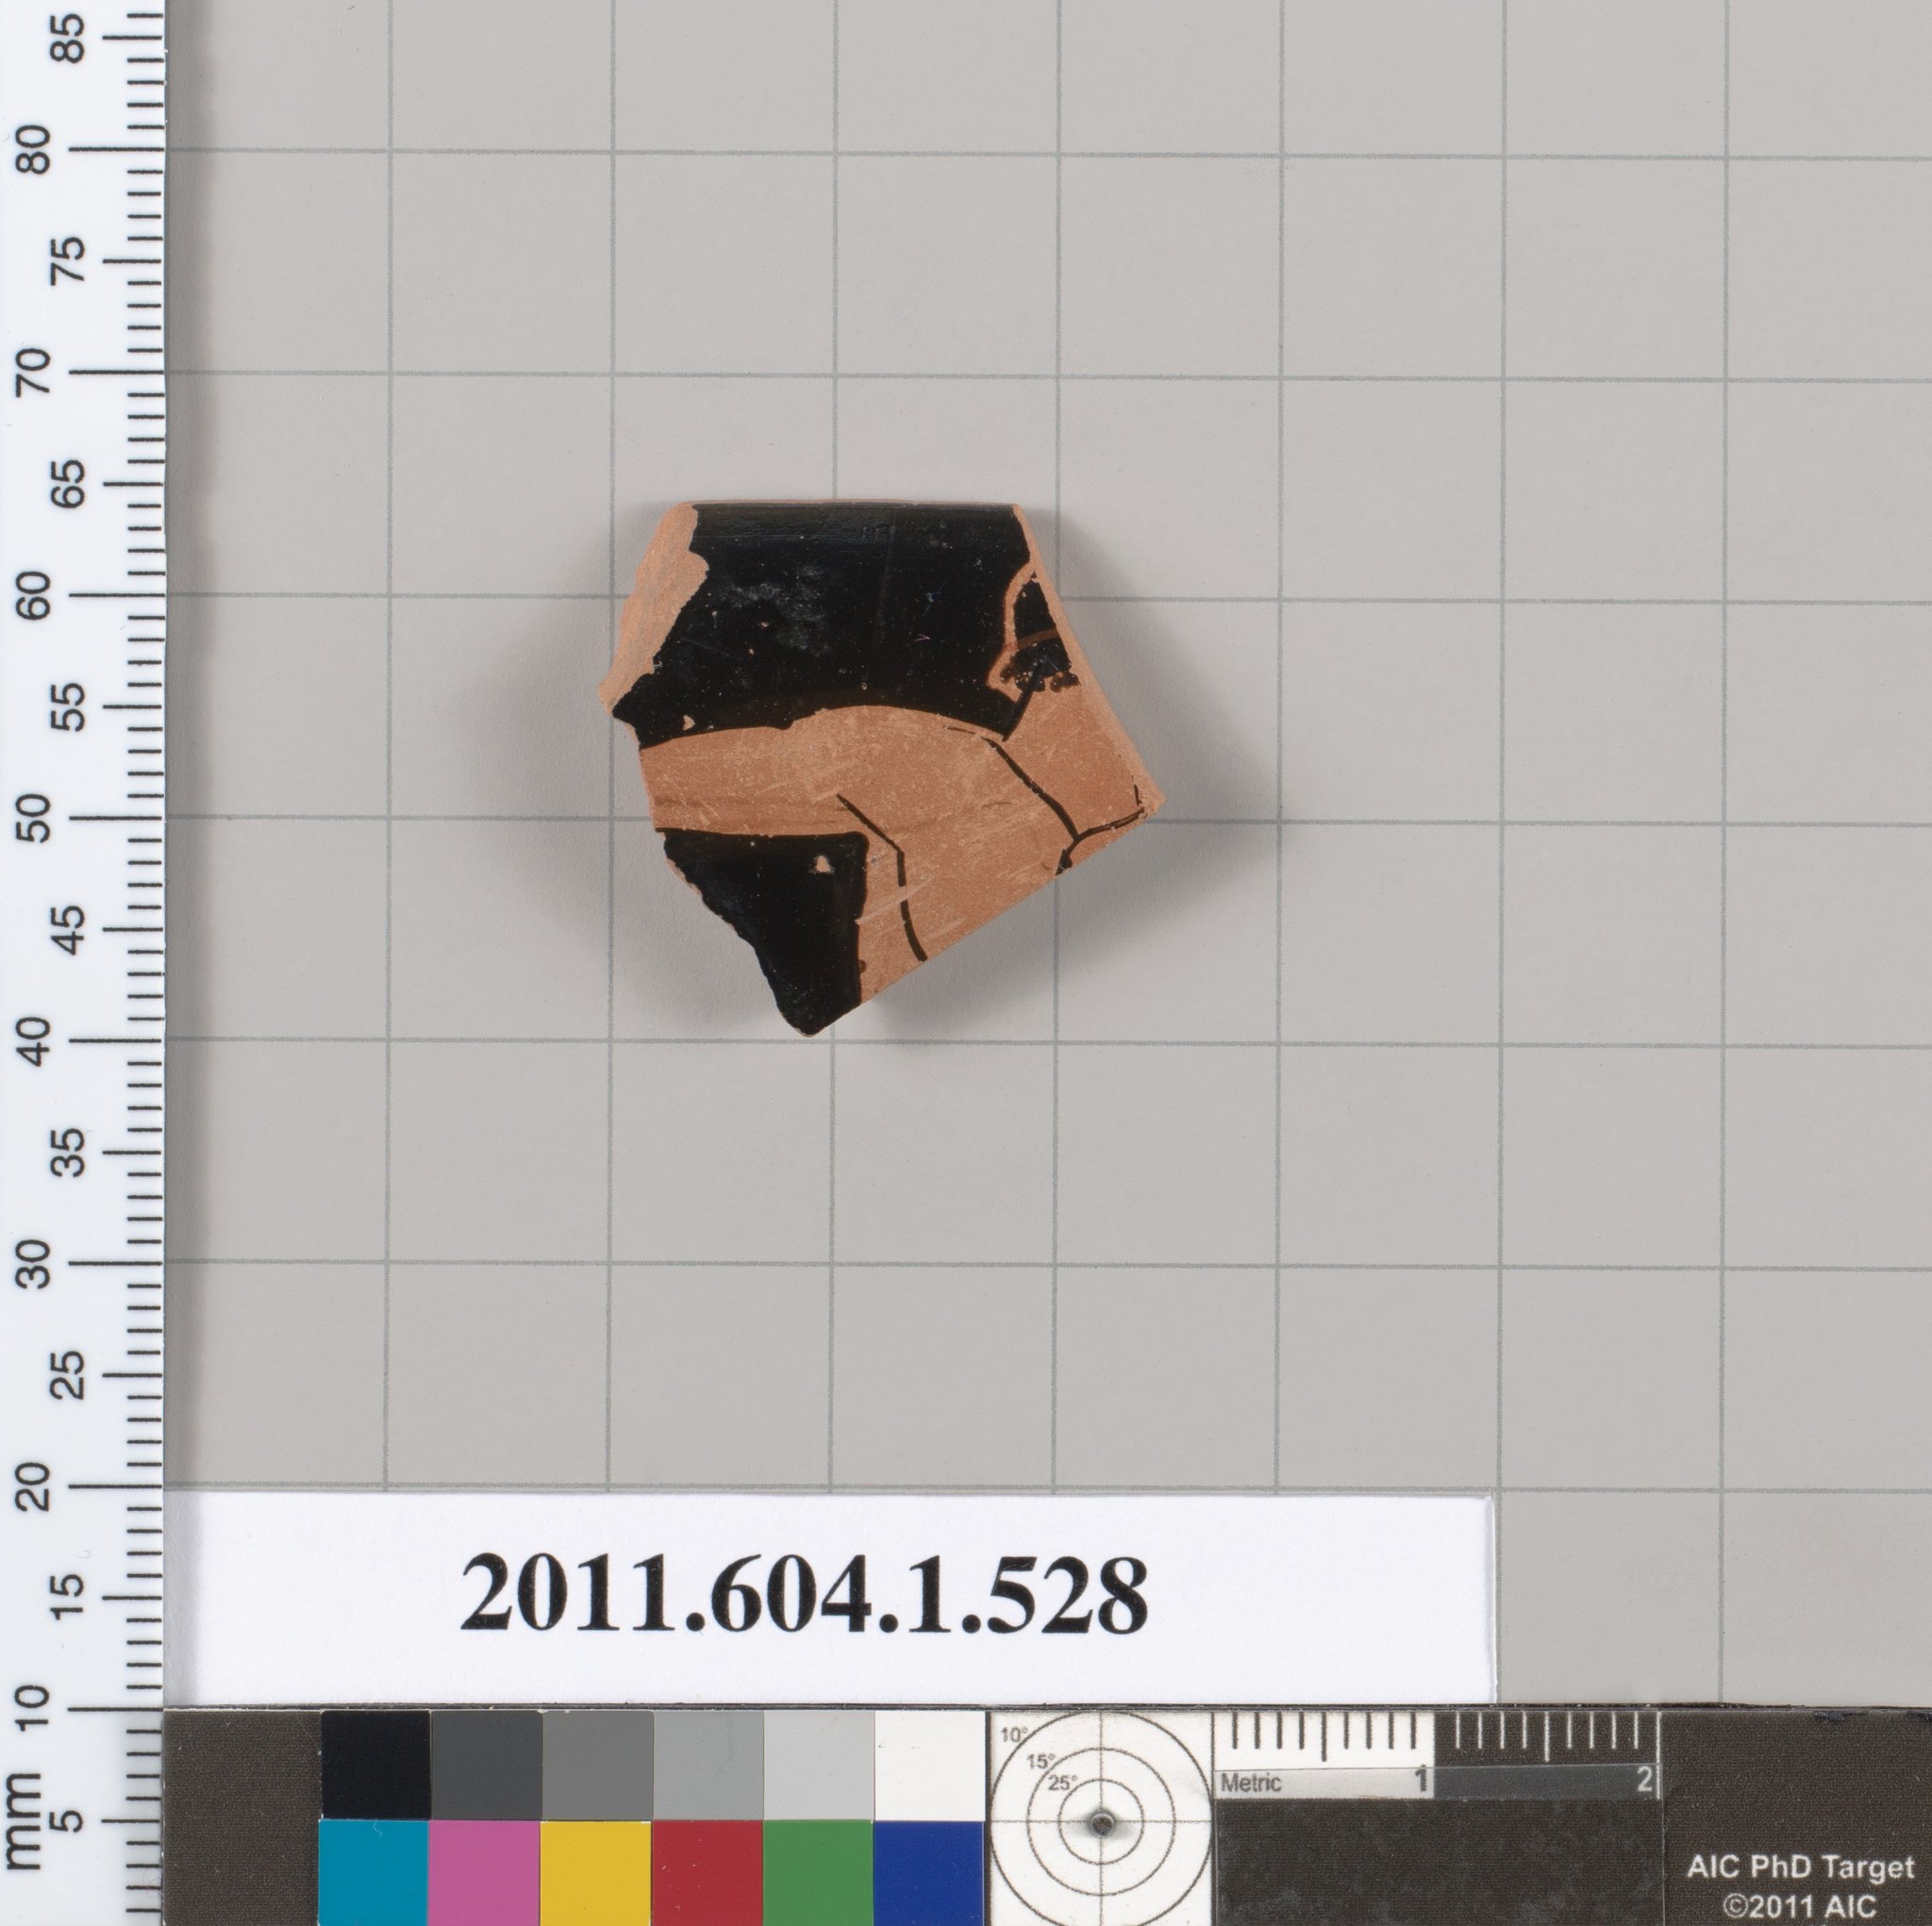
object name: kylix fragment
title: Terracotta rim fragment of a kylix (drinking cup)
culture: greek, attic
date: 480-470 BCE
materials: terracotta